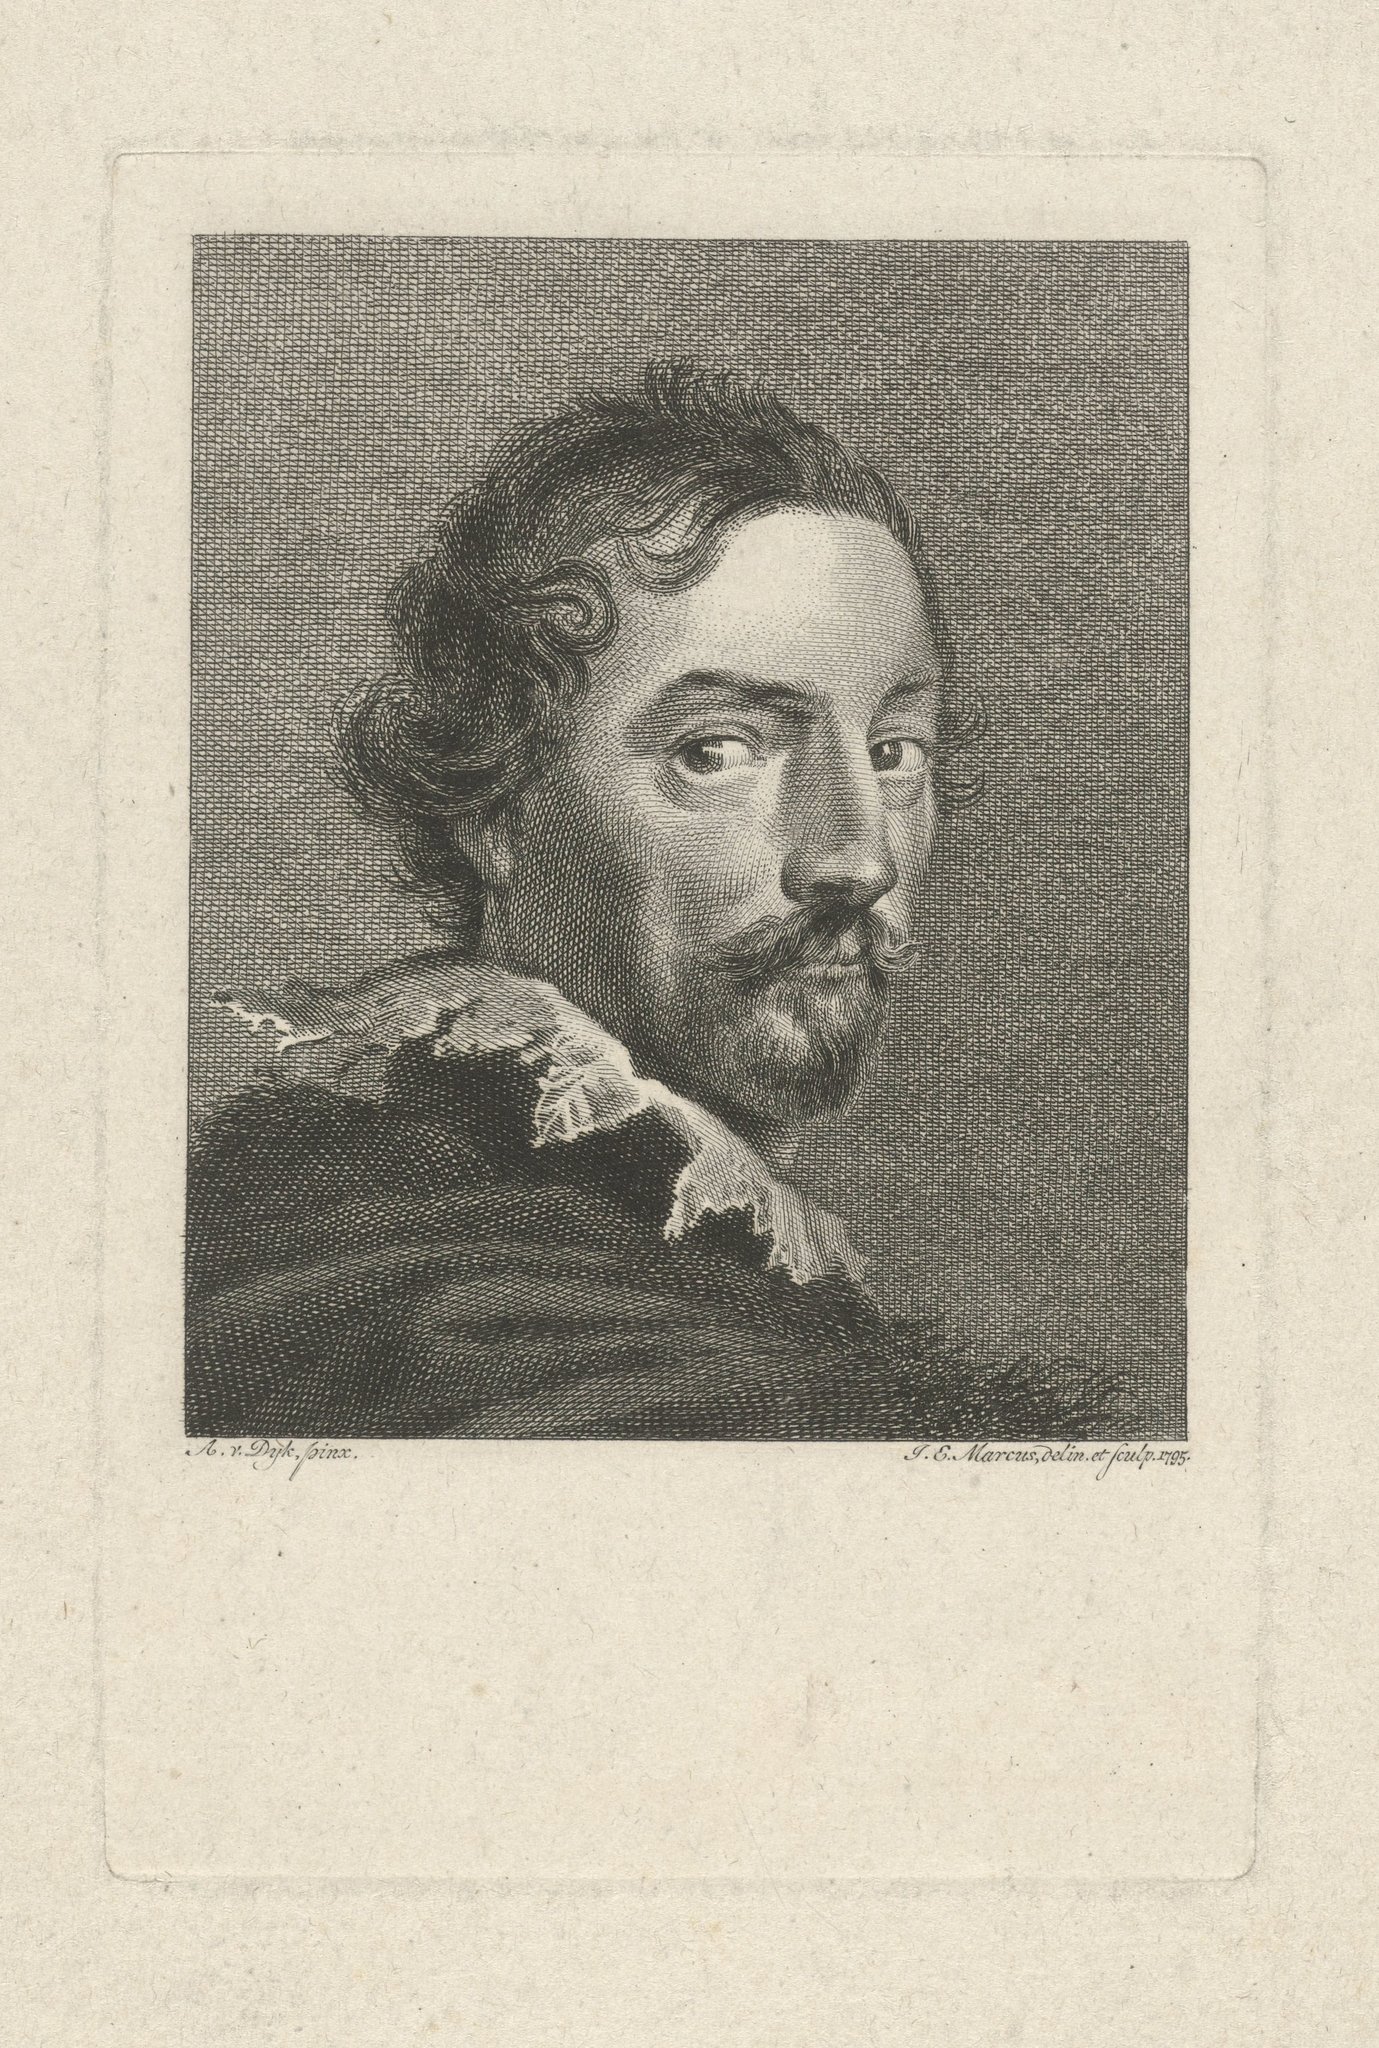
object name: print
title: Portret van een onbekende man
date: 1795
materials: paper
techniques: engraving, etching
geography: amsterdam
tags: adult man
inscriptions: collector's mark: Lugt 2228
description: Buste van een onbekende man, over zijn schouder kijkend.